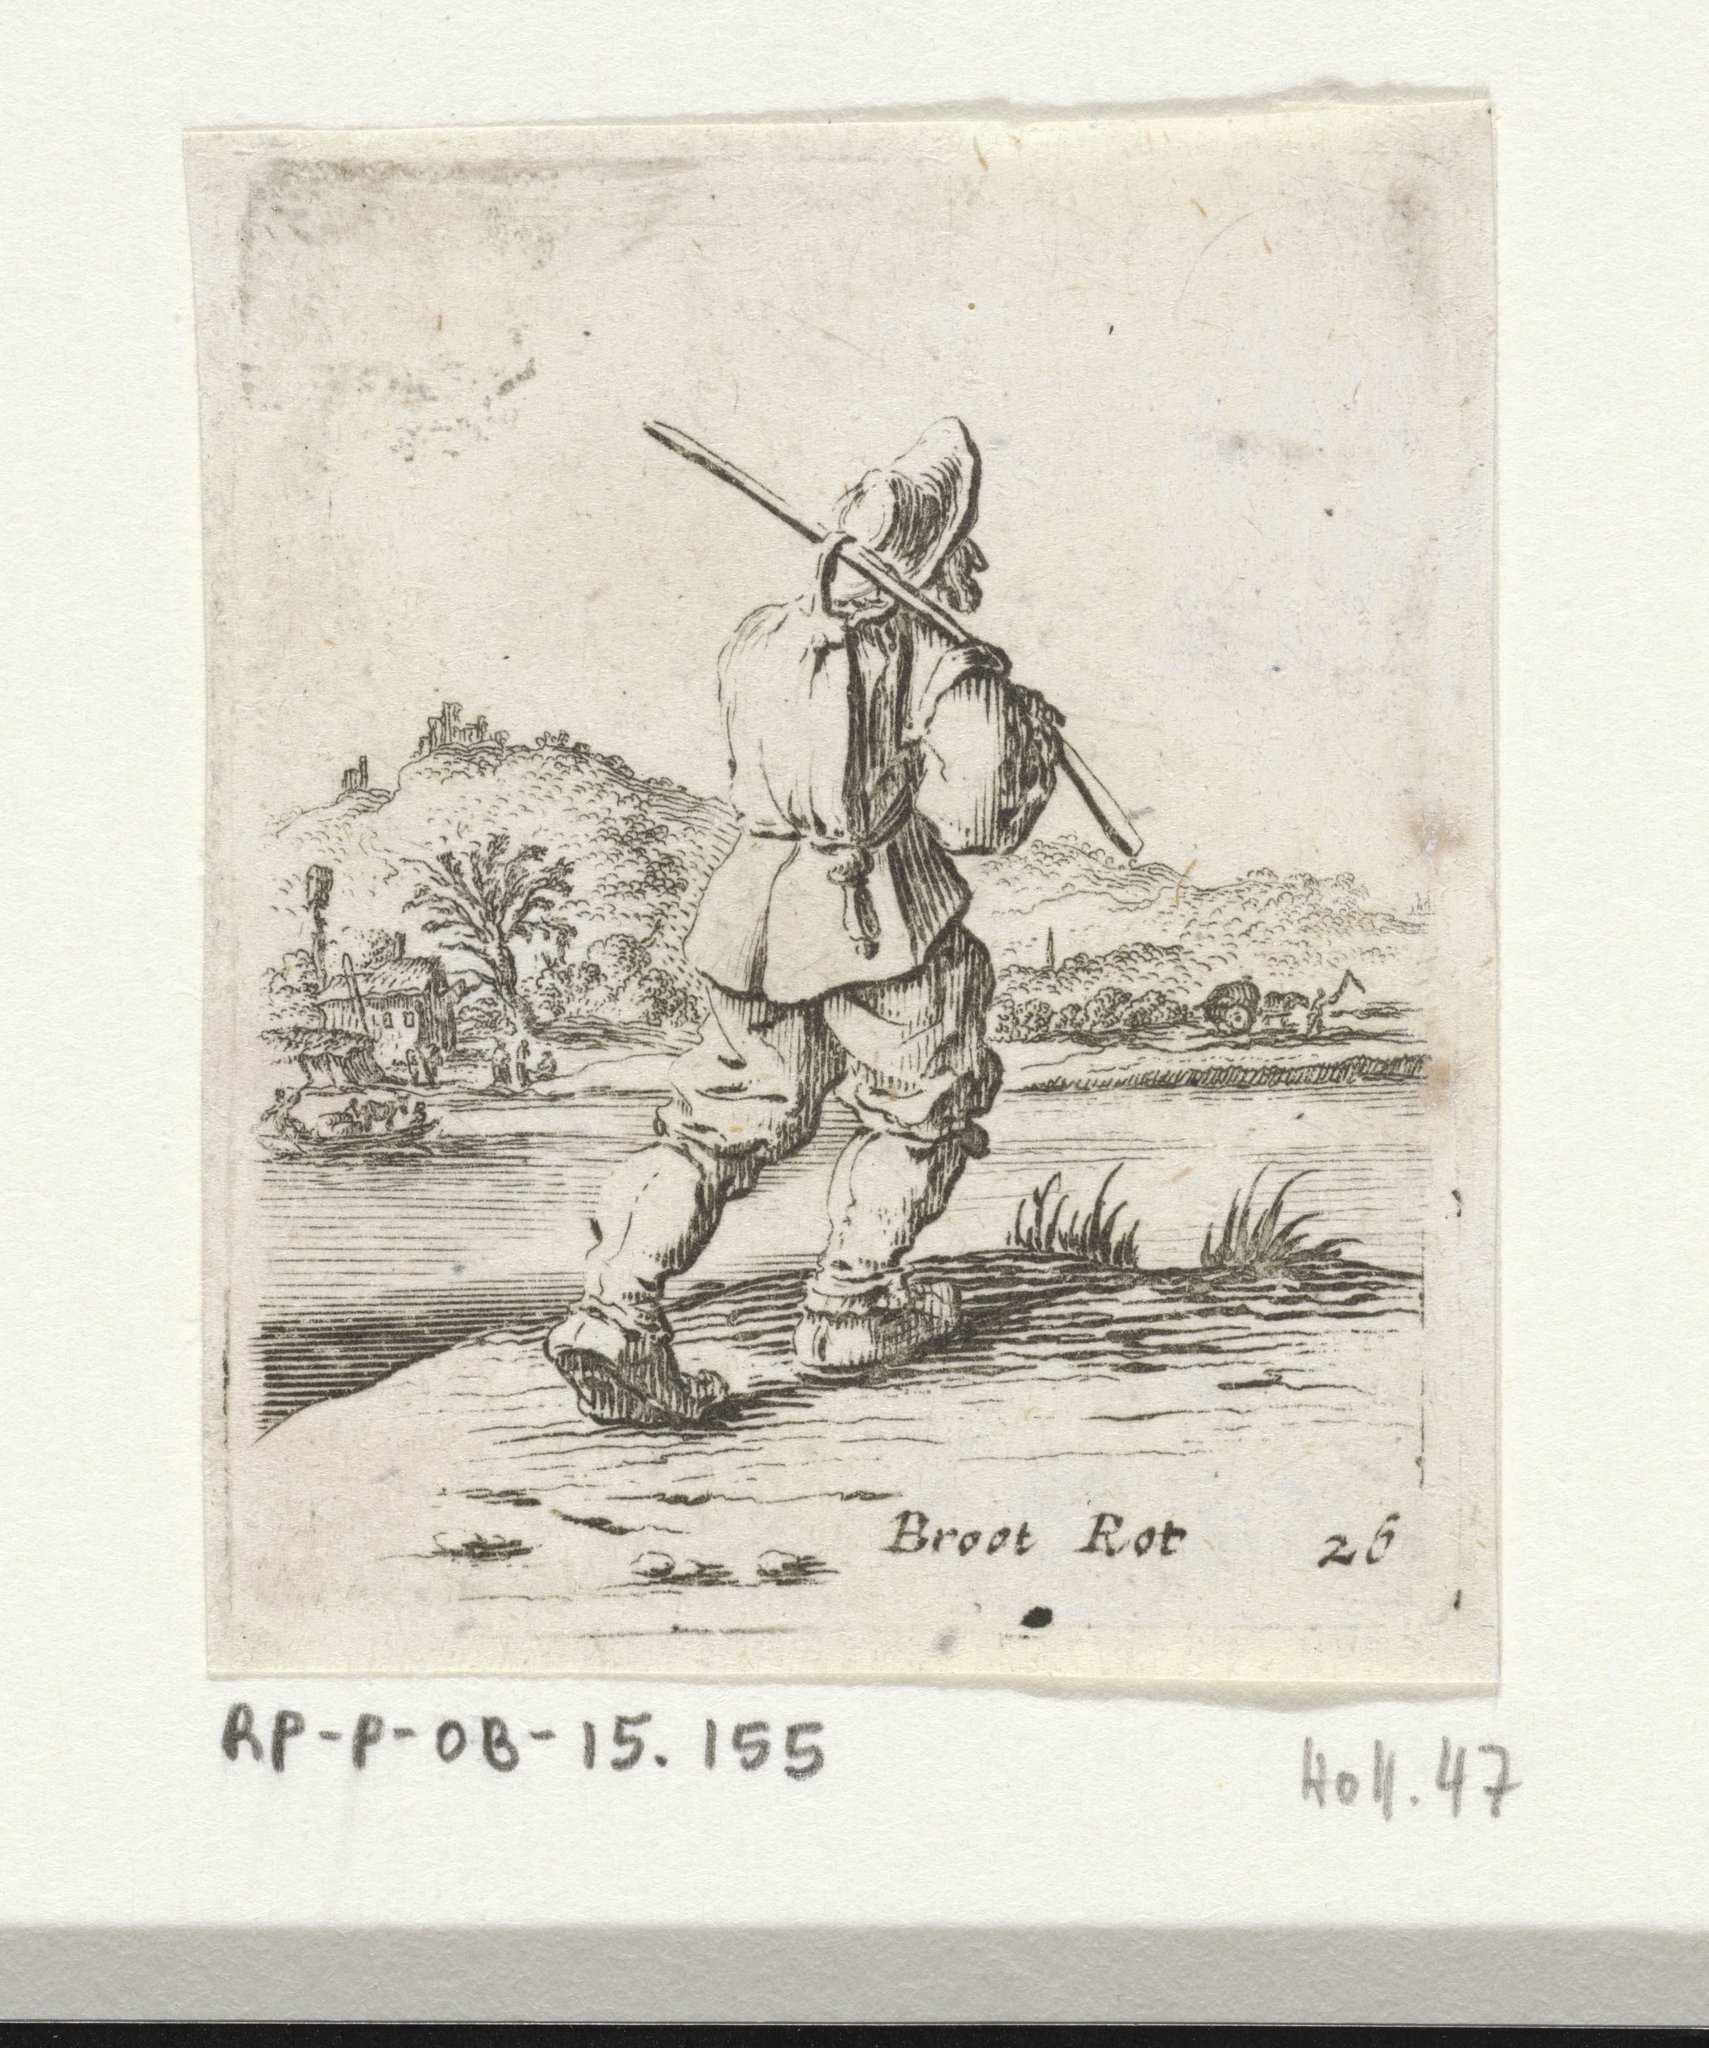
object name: print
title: Man met knapzak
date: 1630-1706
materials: paper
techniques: engraving, etching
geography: amsterdam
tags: river, carrying something in basket, bag, rucksack, etc.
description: Een man met een knapzak loopt langs de waterkant. Op de rivier een boot en aan de overkant een heuvellandschap met huizen. De prent maakt deel uit van een serie van 32 prenten met genretaferelen.